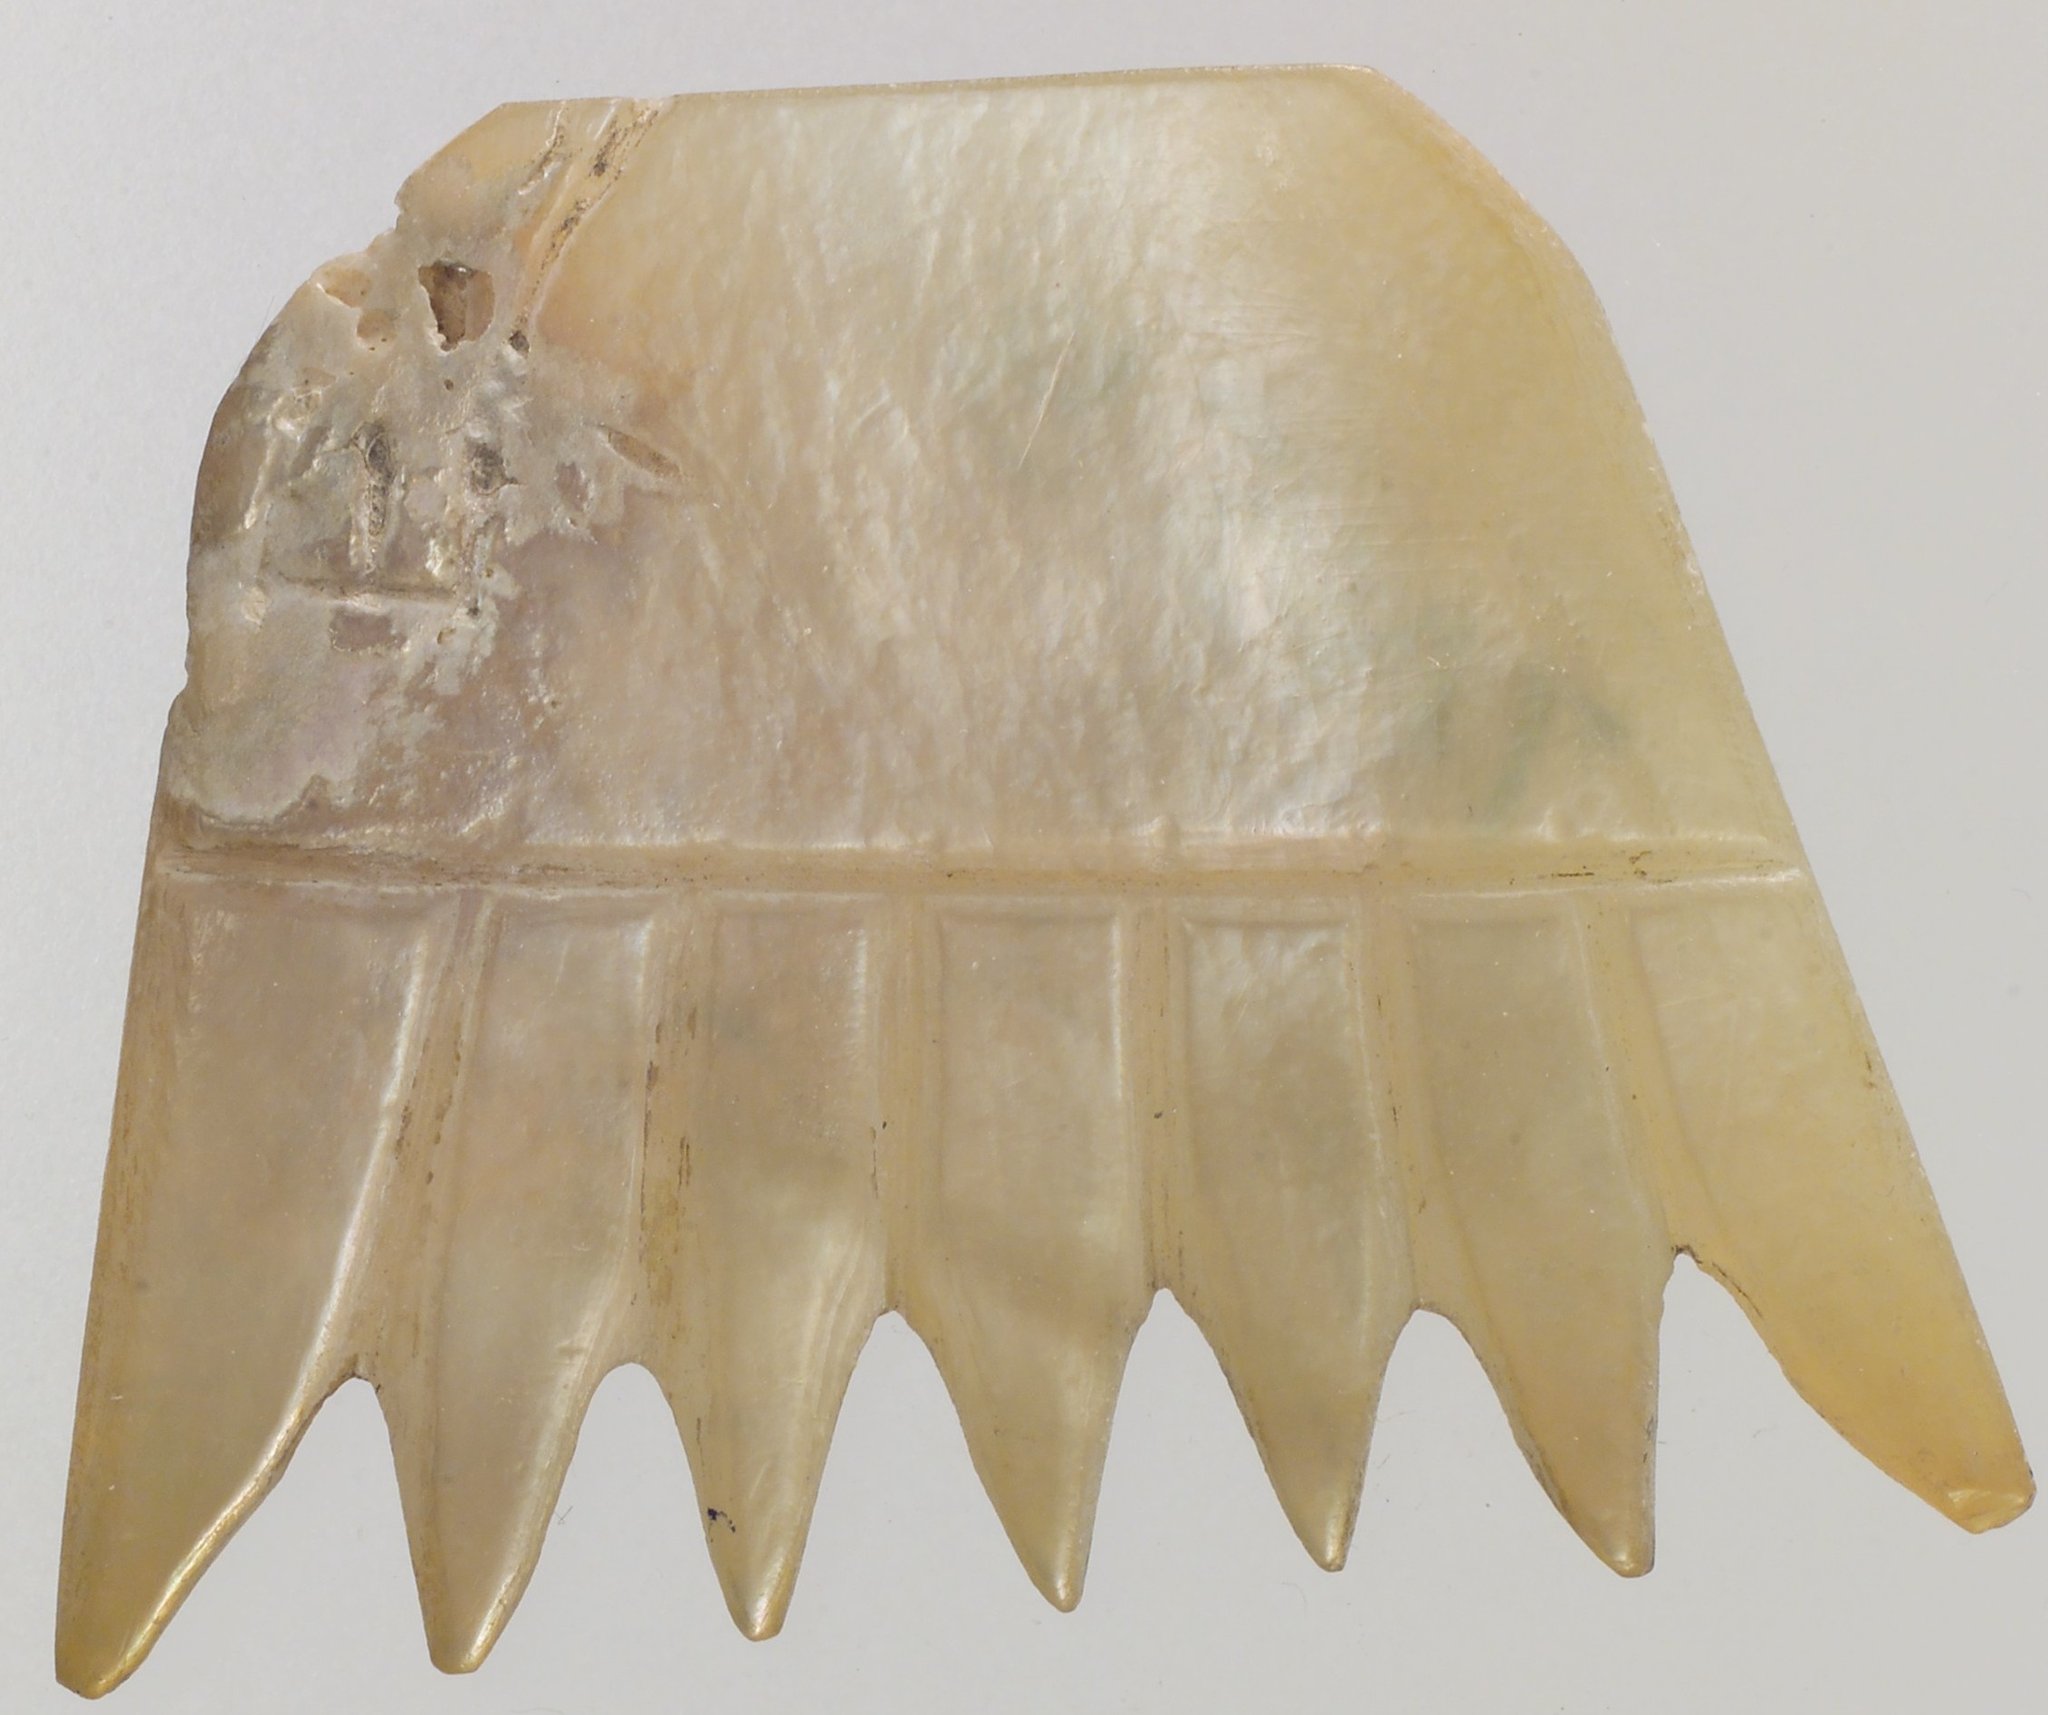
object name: inlay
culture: sumerian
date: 2600-2500 BCE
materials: shell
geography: mesopotamia